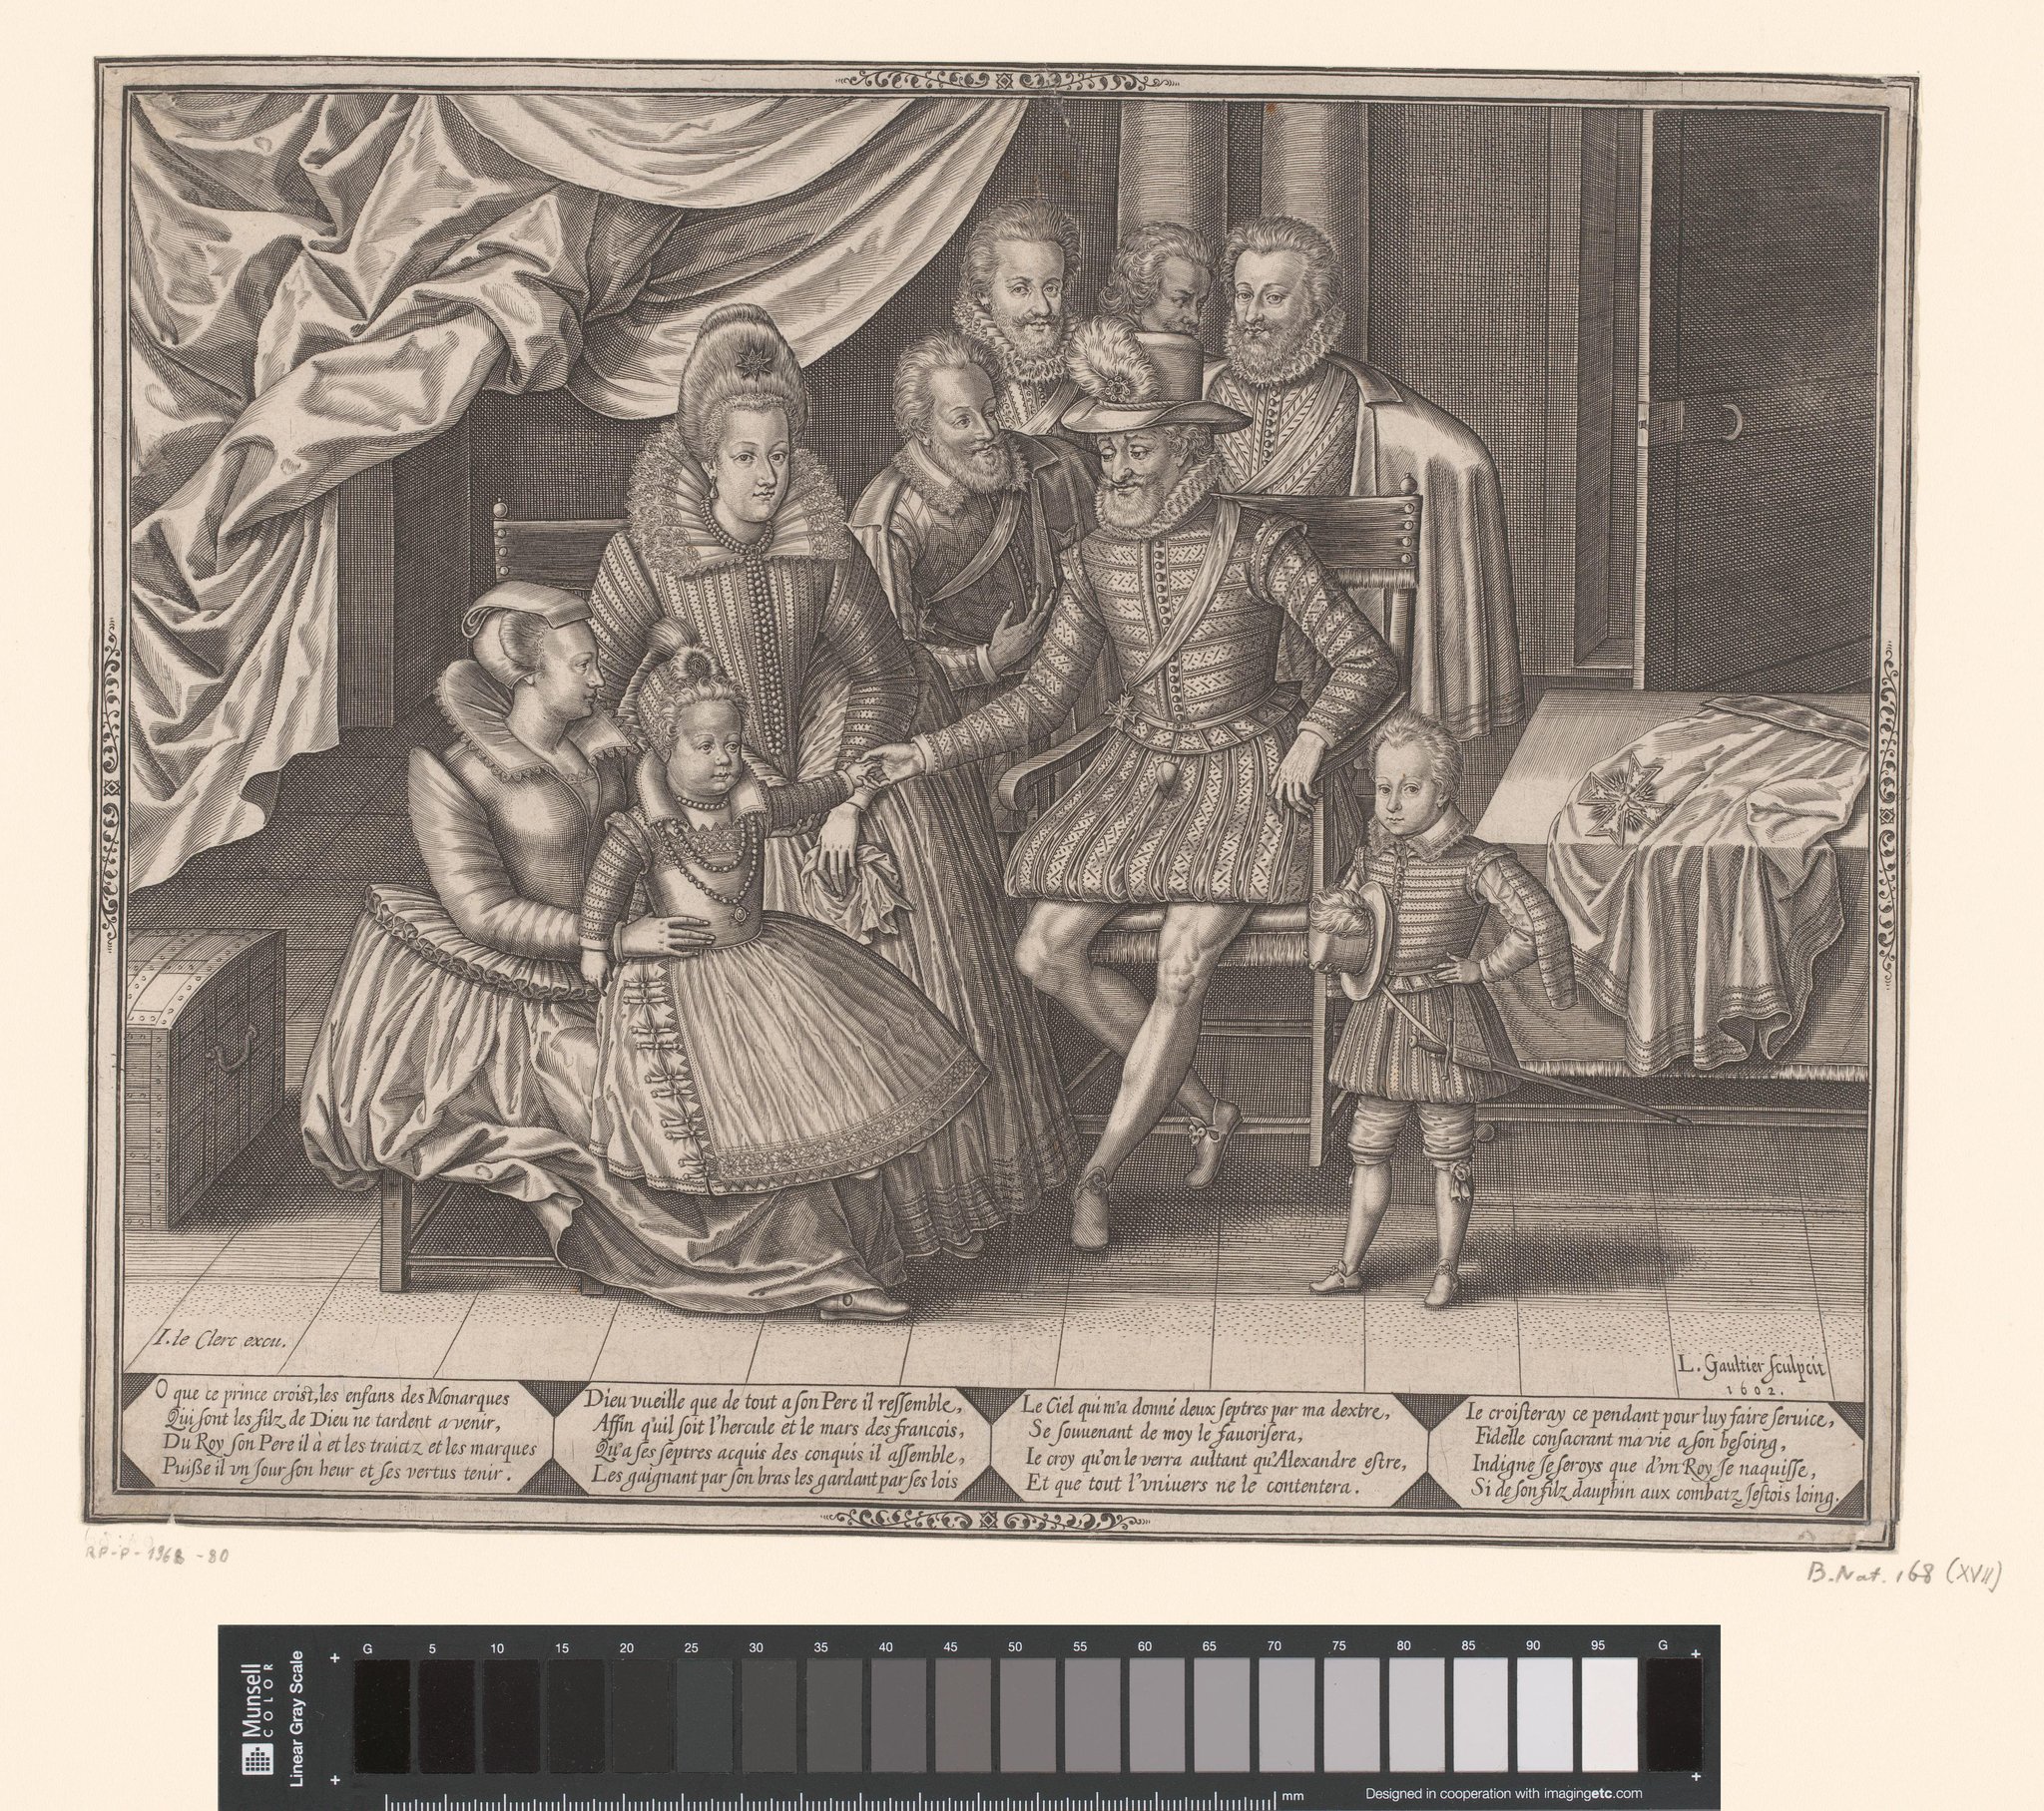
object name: print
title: Familieportret met Hendrik IV van Frankrijk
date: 1602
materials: paper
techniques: engraving, etching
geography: paris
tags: paris, hendrik iv (koning van frankrijk en navarra), historical persons, family of the sovereign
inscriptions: collector's mark: Lugt 2760, collector's mark: Lugt 2228